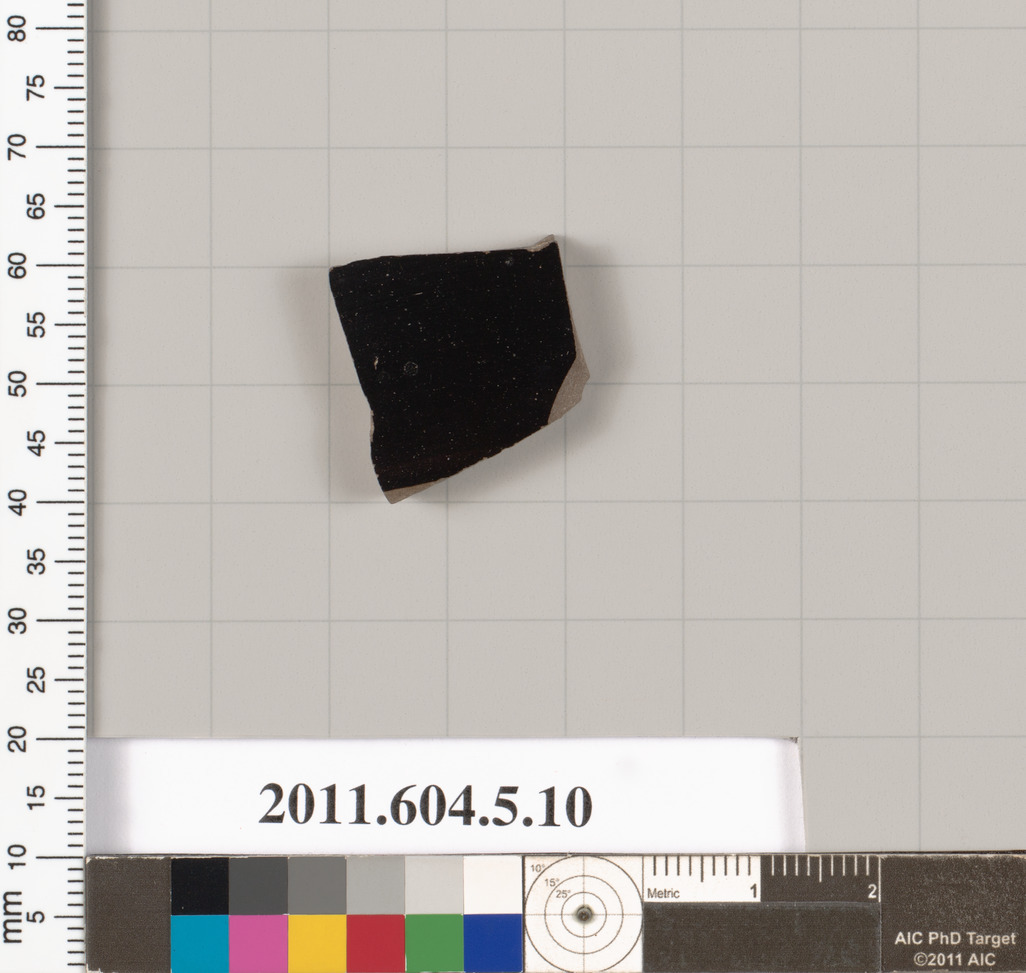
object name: kylix fragment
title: Terracotta fragment of a kylix (drinking cup)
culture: greek, attic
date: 475-451 BCE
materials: terracotta